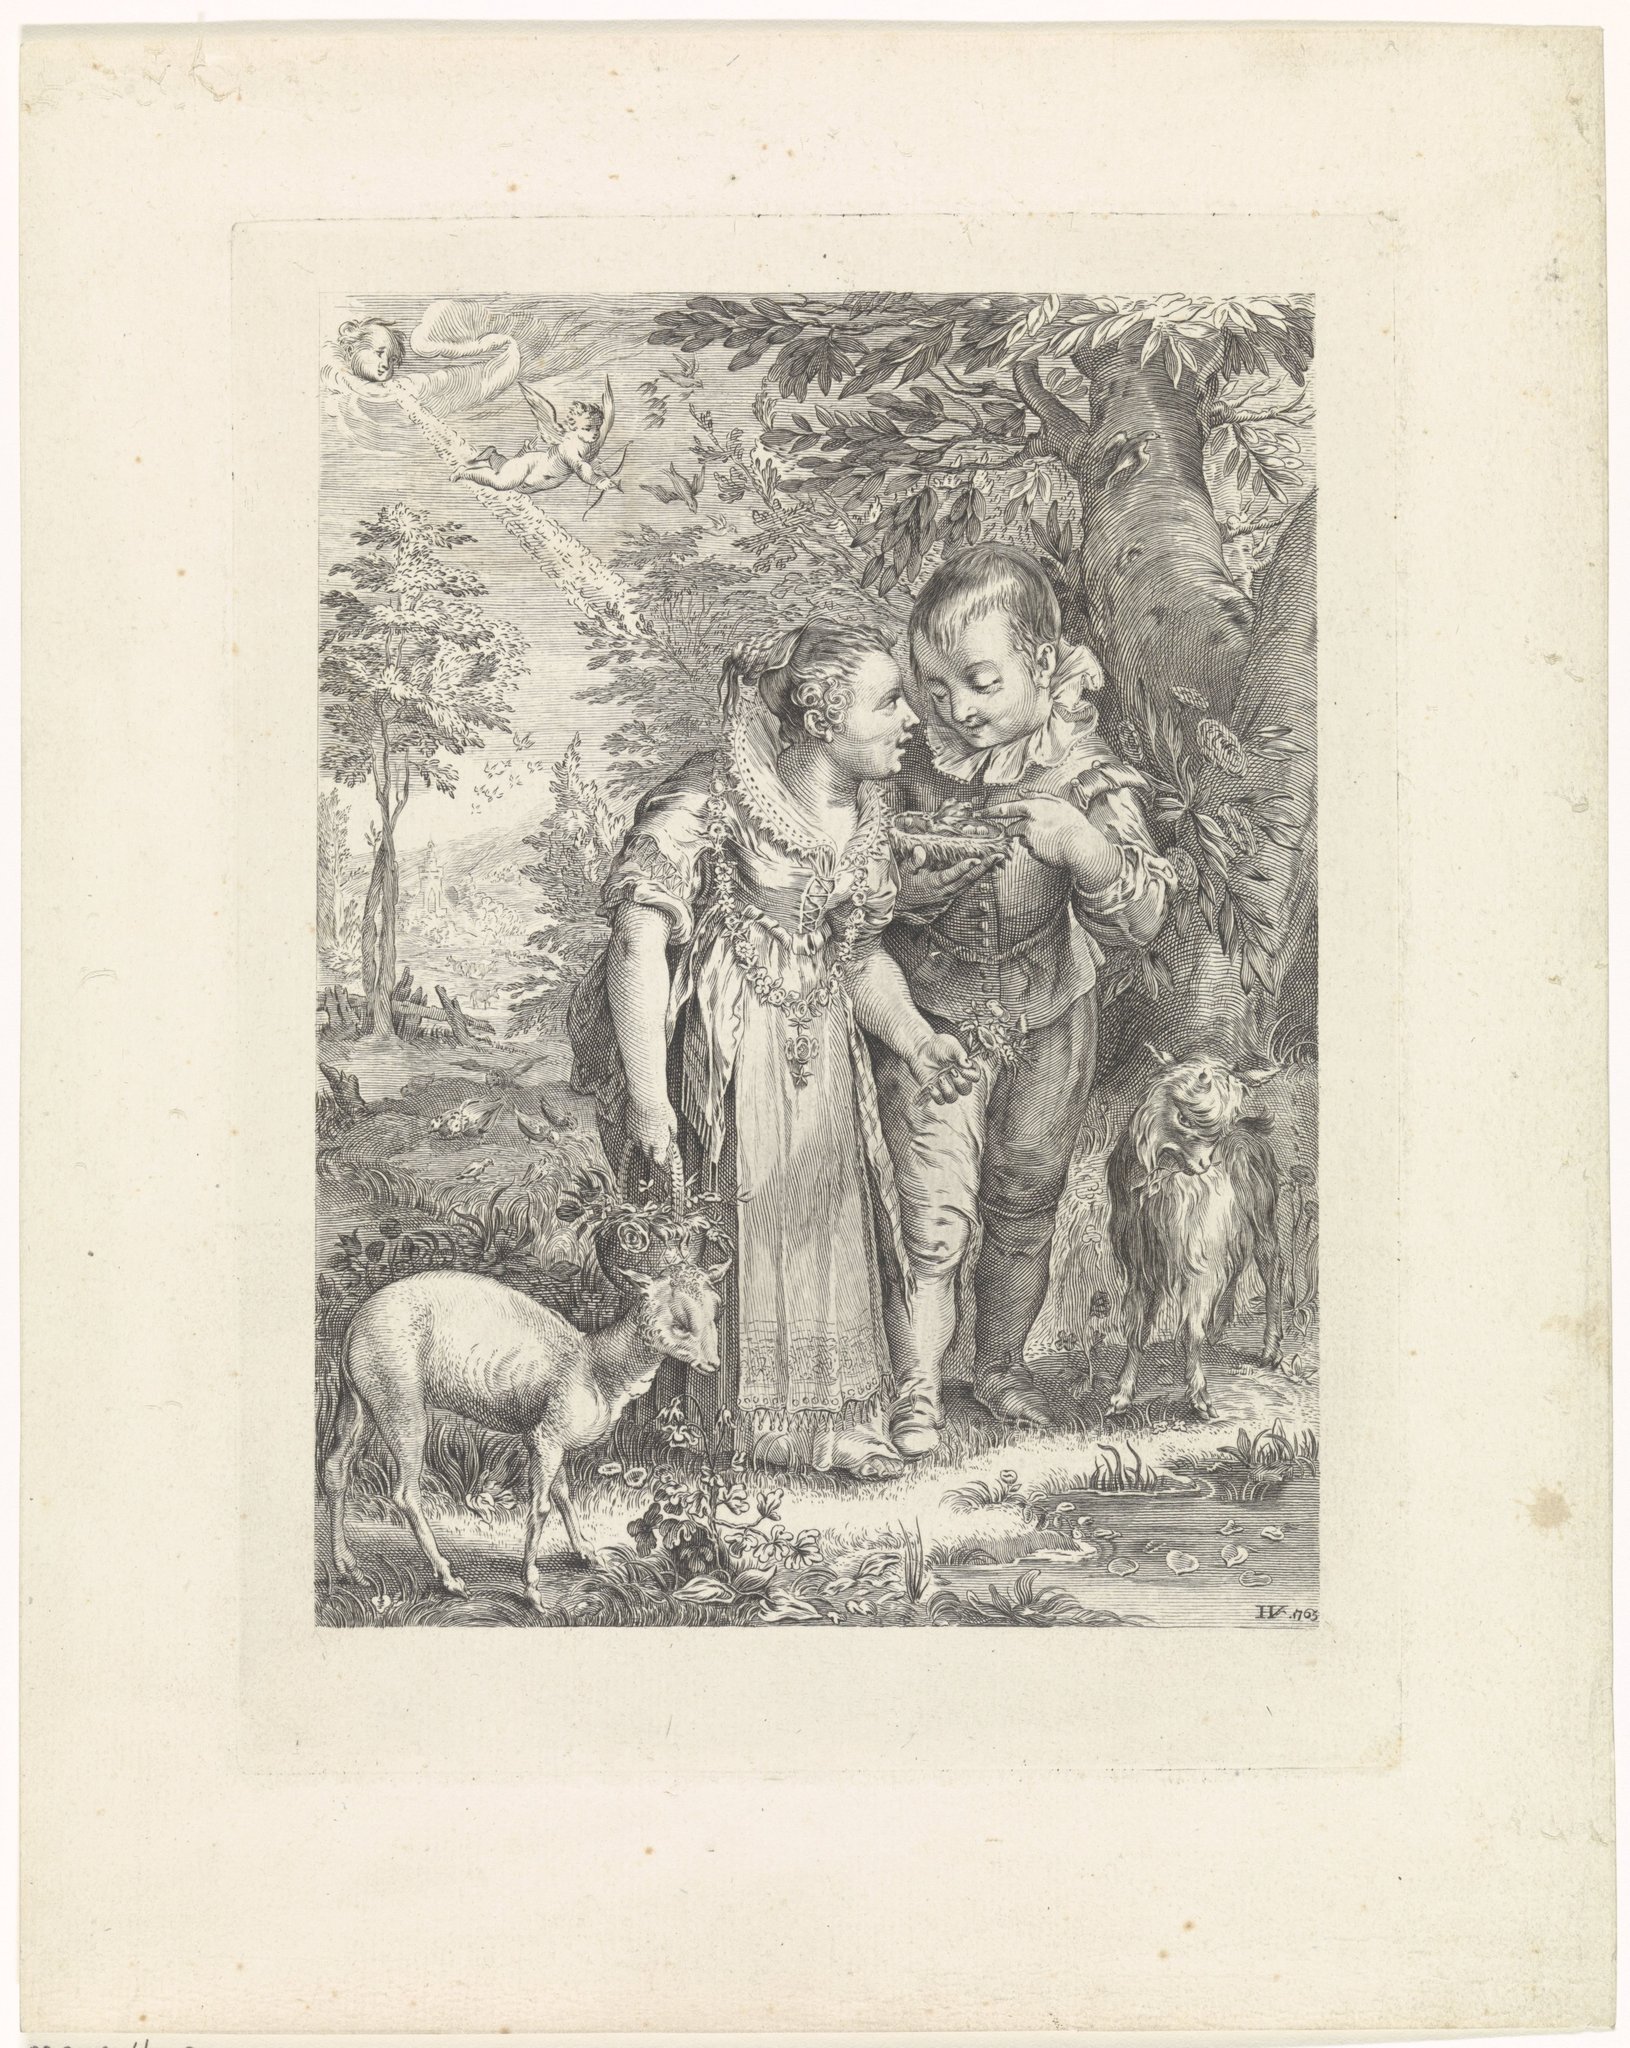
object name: print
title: Lente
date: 1765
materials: paper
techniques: engraving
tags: child robbing bird's nests (+ variant), spring, 'ver'; 'primavera' (ripa), spring ~ human activities (the four seasons of the year)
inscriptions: dedication: ‘geoffreerd aan de heer Pieter van den Eijk/ H. Vinkeles 1765’, collector's mark: Lugt 240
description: Een jongen en een meisje in een landschap. De jongen toont het meisje, met bloemenmandje in de hand, een vogelnest. Rechtsboven richt Amor zijn pijl op hen.